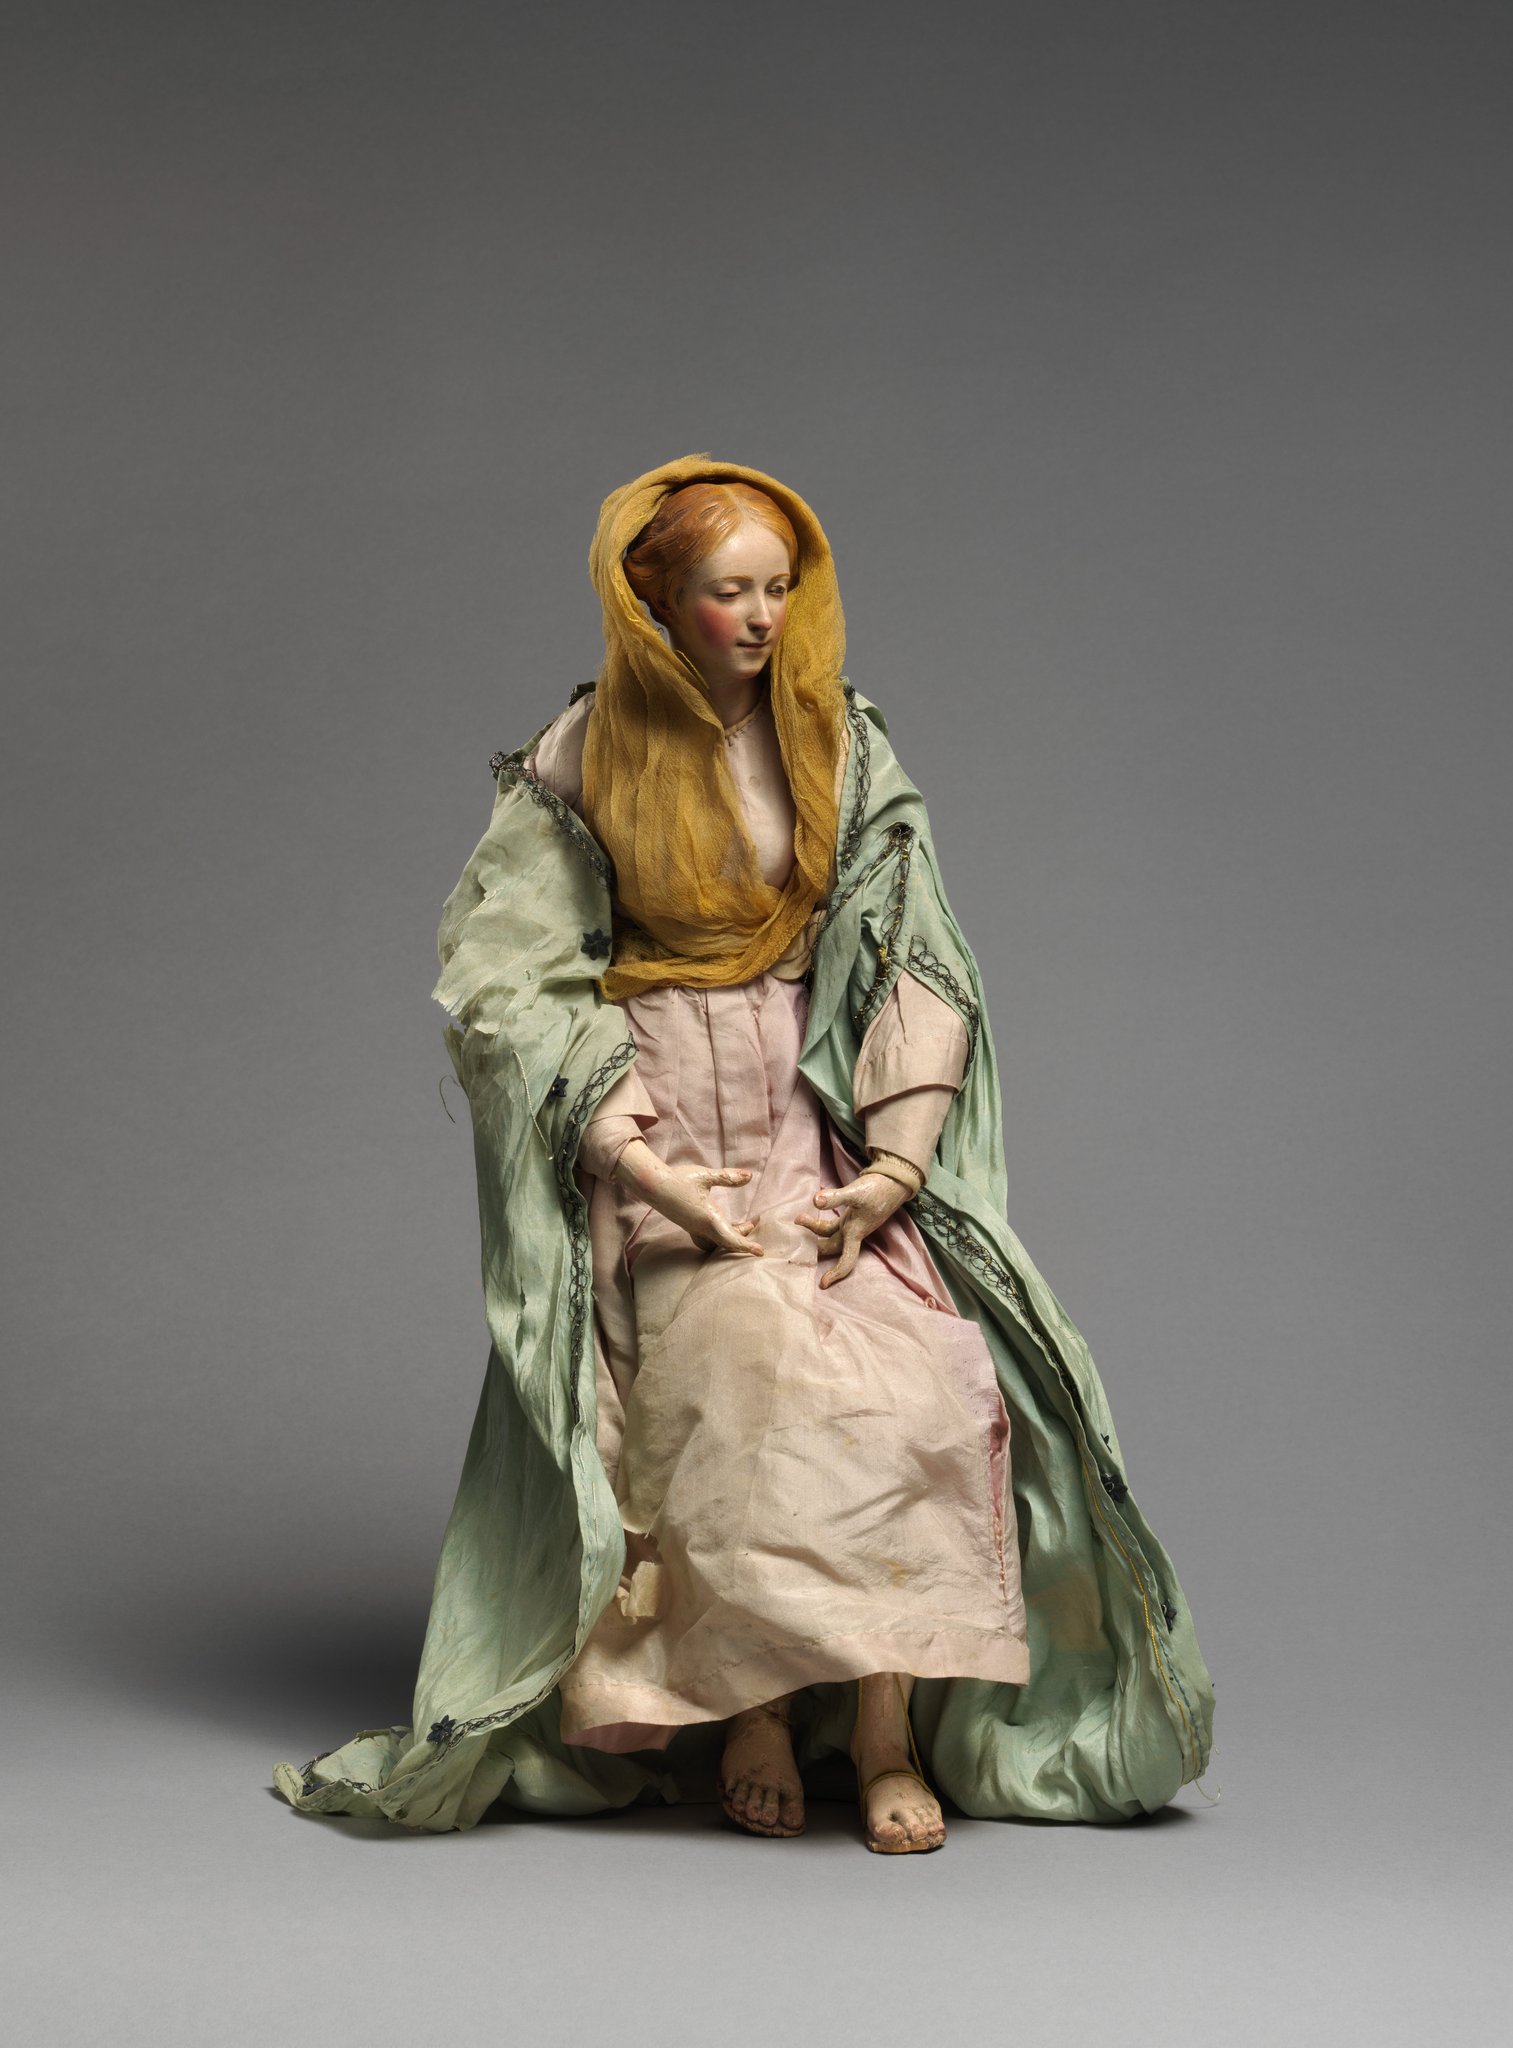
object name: crèche figure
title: Mary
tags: virgin mary